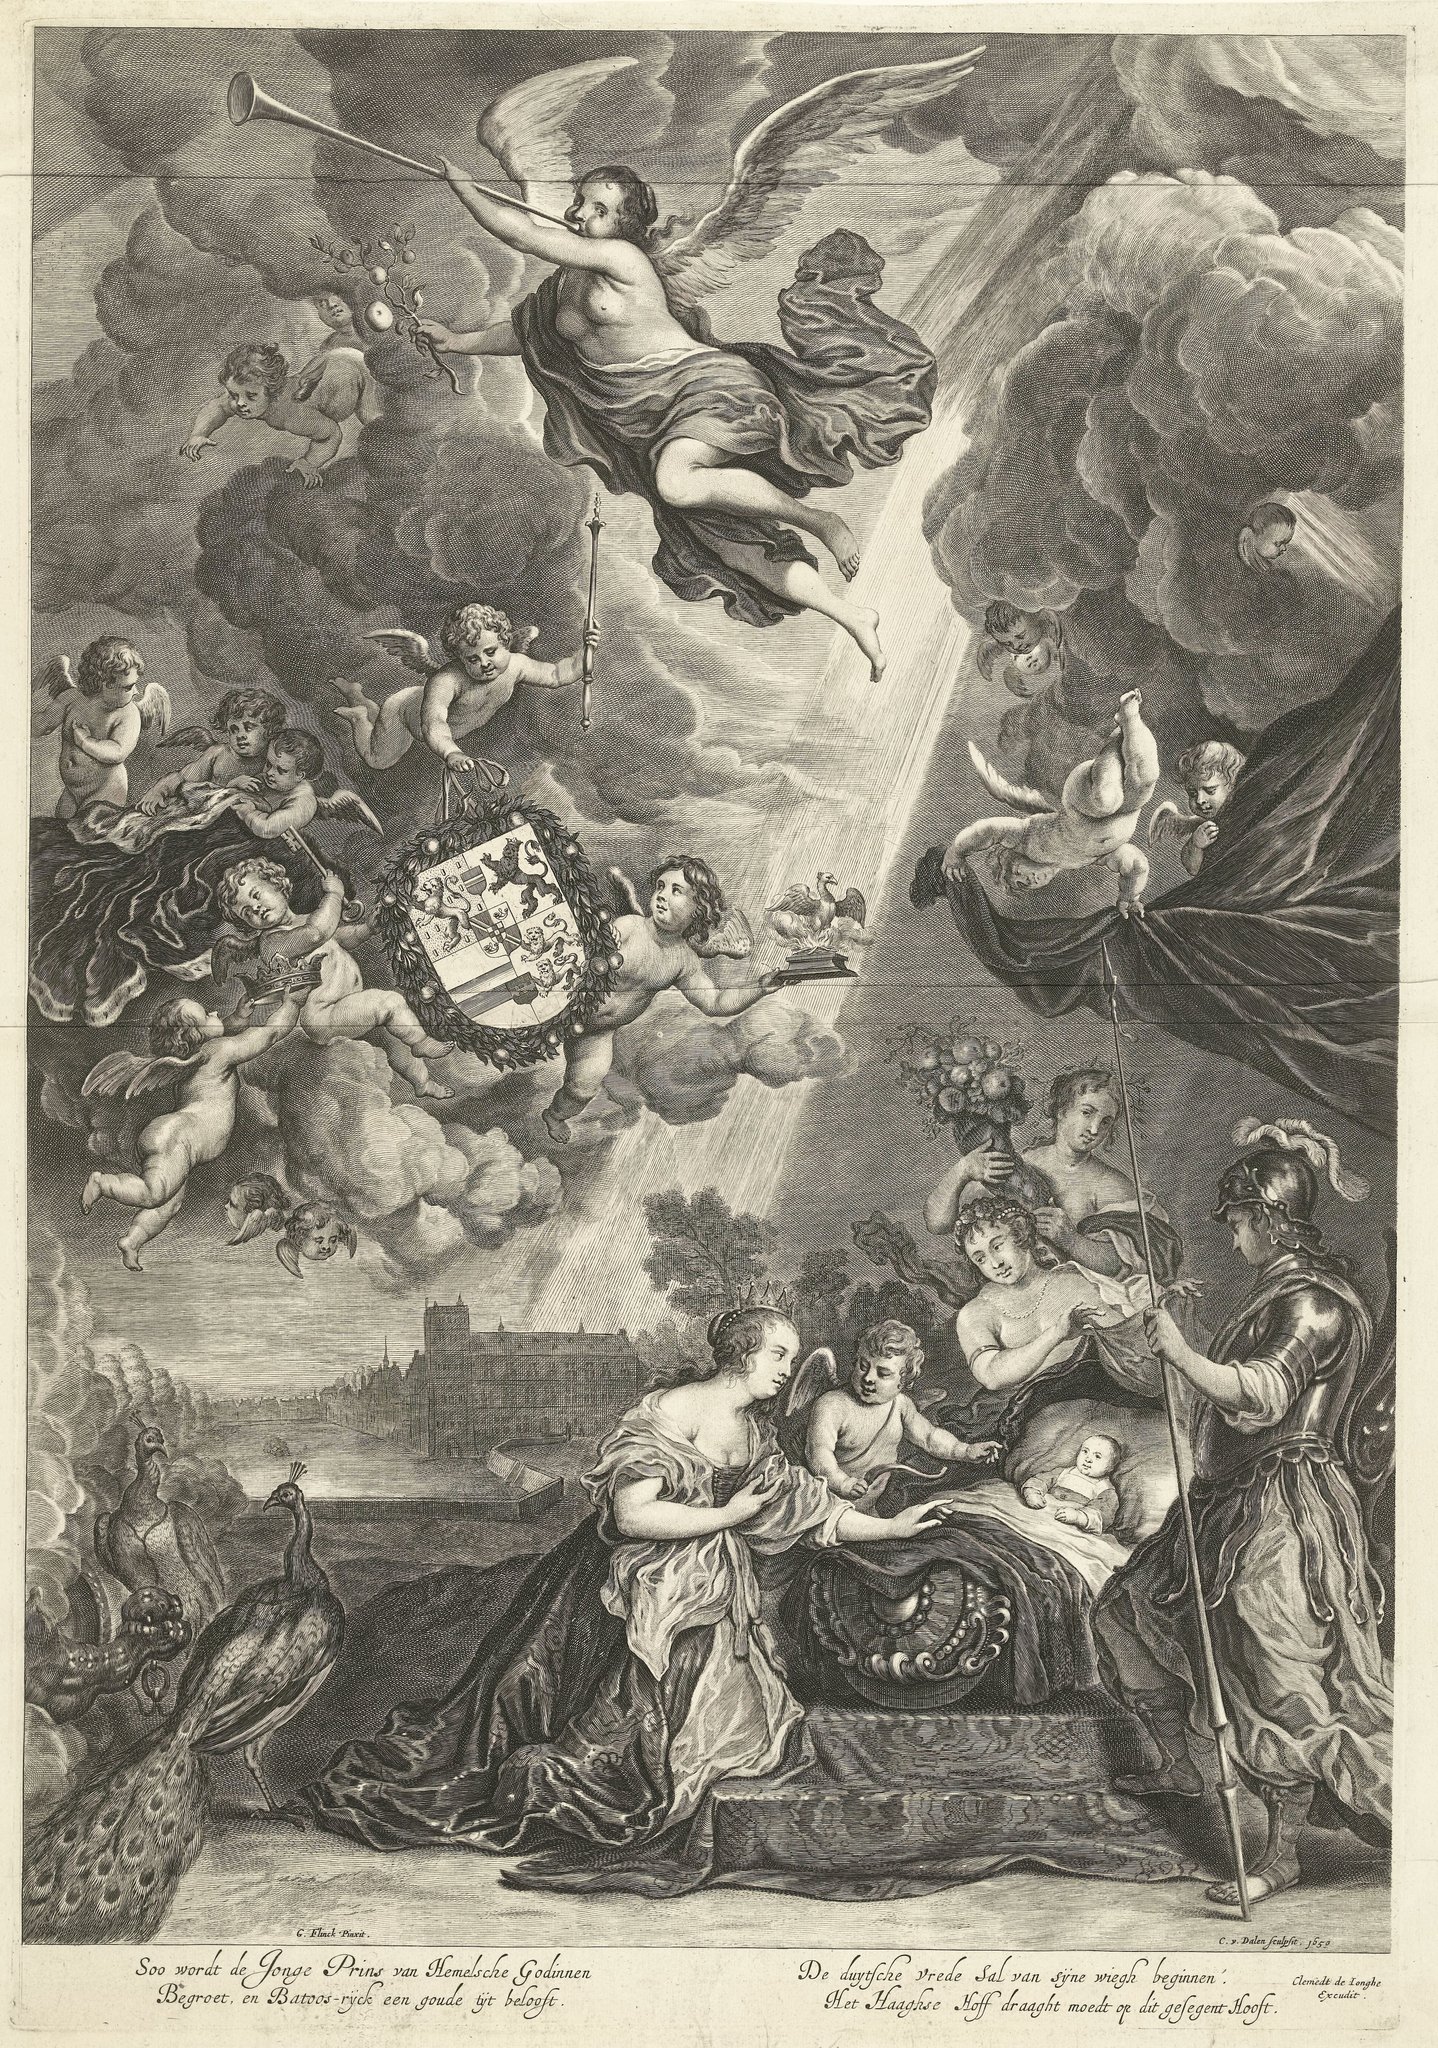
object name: print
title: Allegorie op geboorte van Willem III, prins van Oranje-Nassau in 1650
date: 1650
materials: paper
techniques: engraving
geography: amsterdam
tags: the hague, william iii (prince of orange and king of england, scotland, and ireland), (story of) minerva (pallas, athena), (story of) venus (aphrodite)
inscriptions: date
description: Allegorie op geboorte van prins Willem III, prins van Oranje-Nassau in 1650. In een wieg ligt de prins omringd door onder andere Minerva en Venus en Amor. In de lucht blaast Faam op een loftrompet en dragen kleine engelen symbolen van de toekomstige macht van de nieuwgeborene. In het landschap op de achtergrond een gezicht op de Vijverberg met het Binnenhof te Den Haag. In ondermarge Nederlands vers in vier regels.